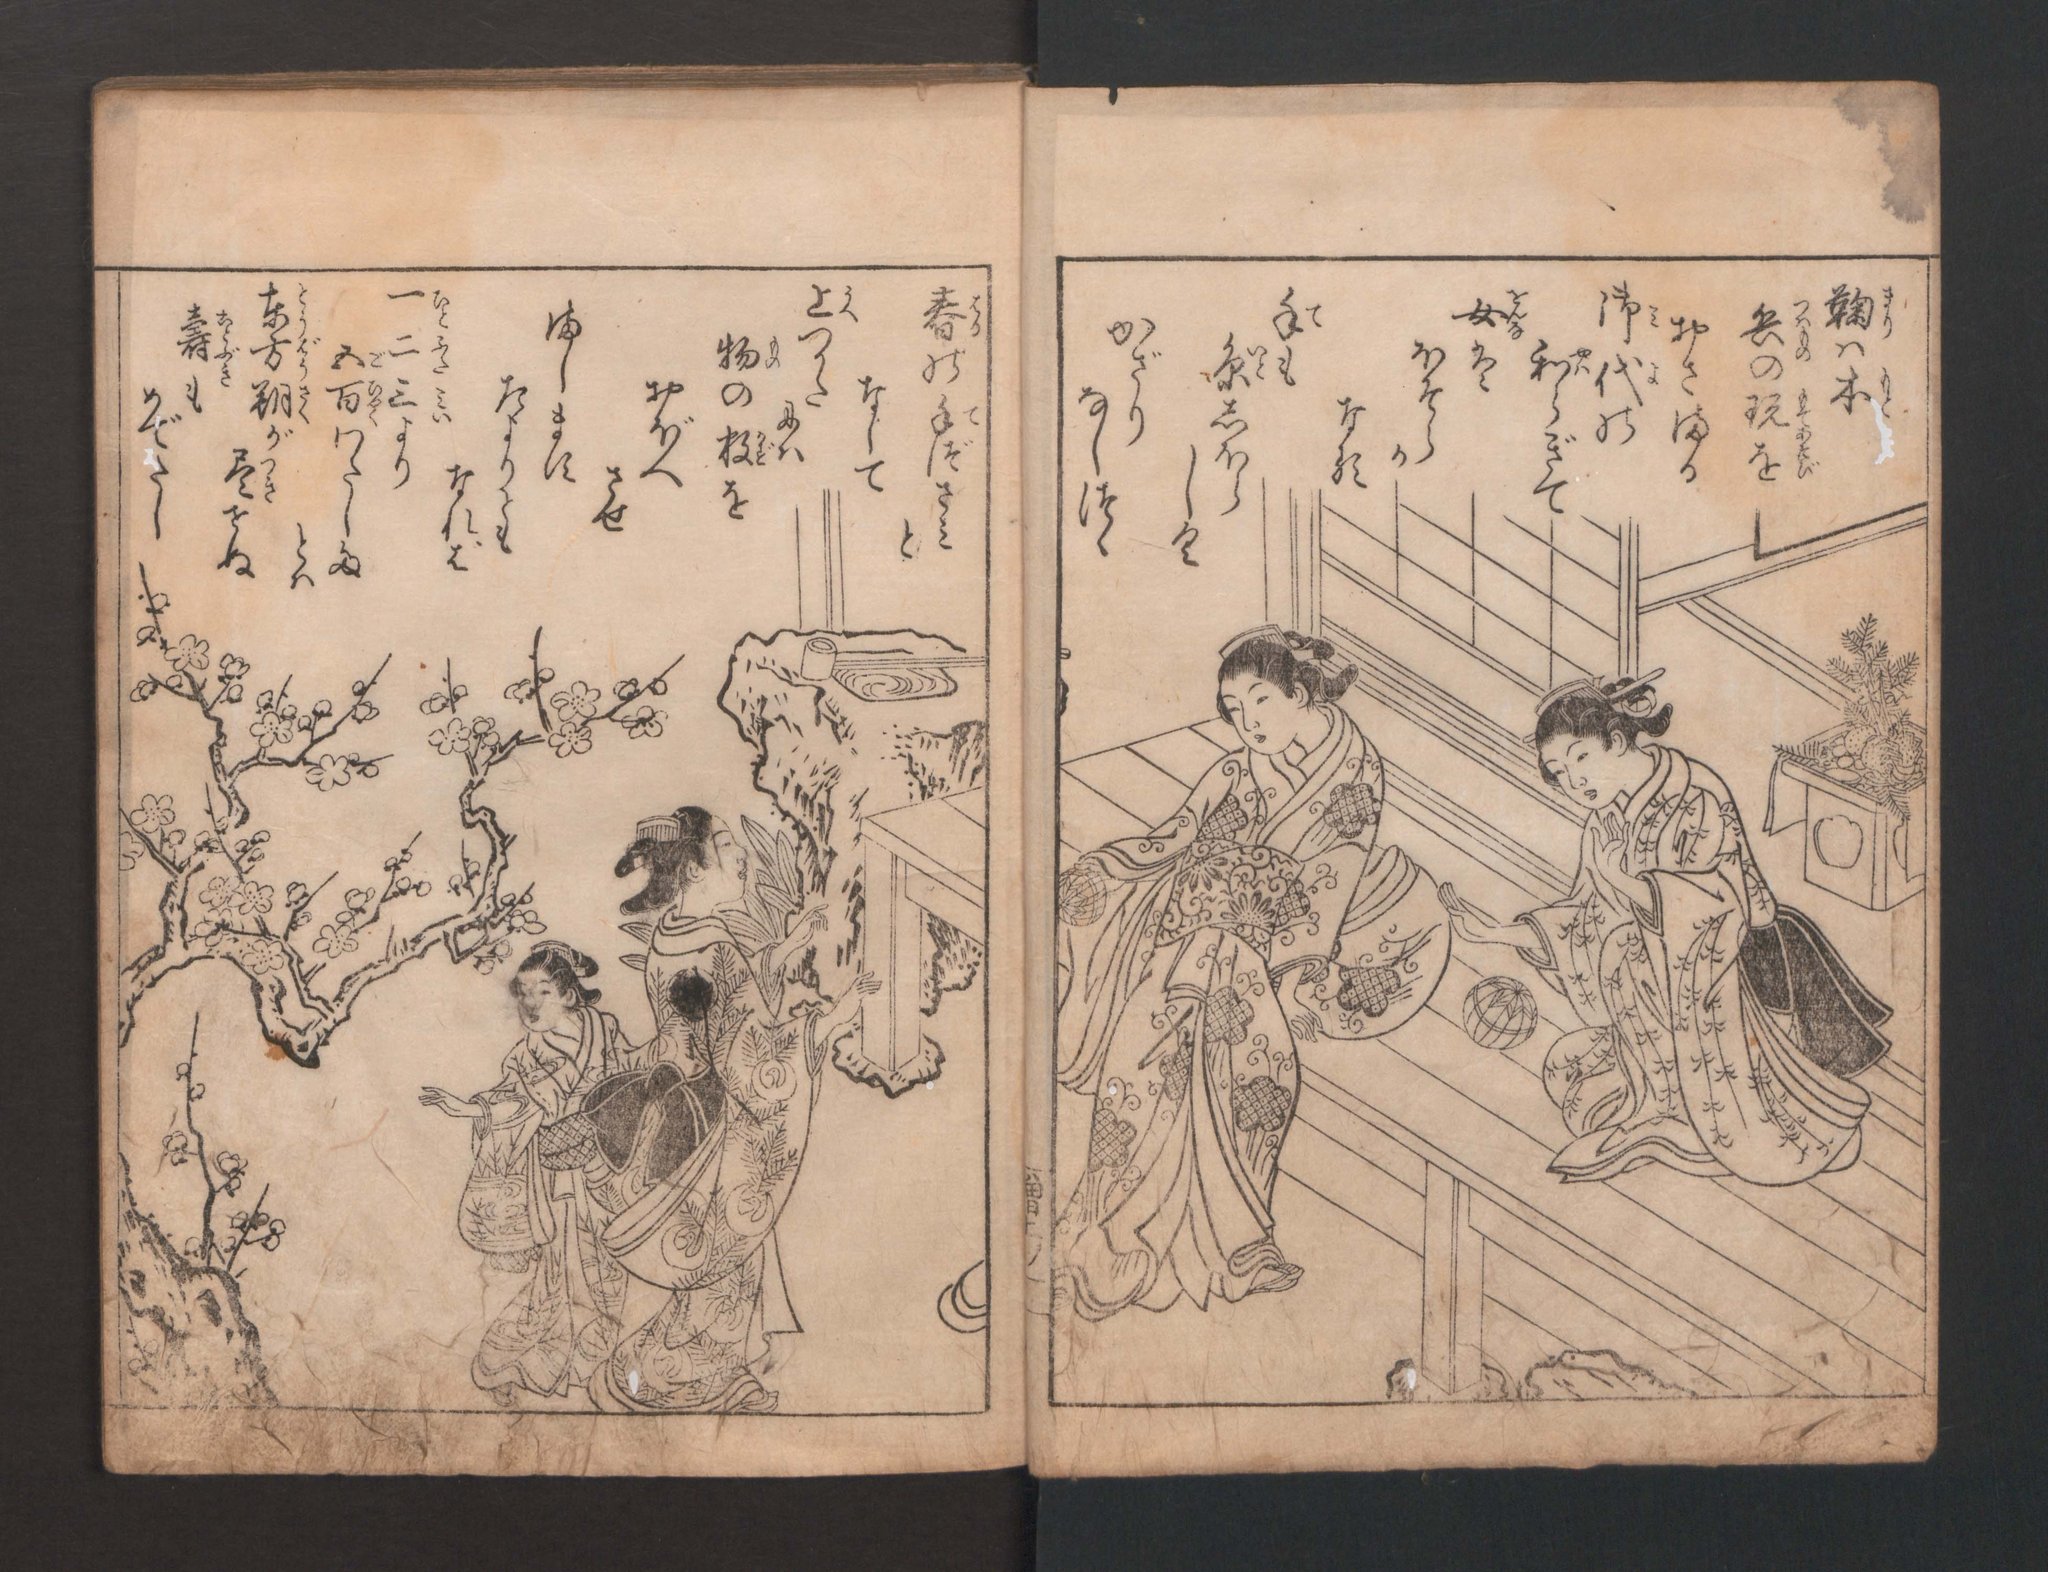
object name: illustrated book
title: True Reflections on the Life and Manners of a Woman (Ehon Masukagami) 絵本十寸鏡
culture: japanese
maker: nishikawa sukenobu 西川祐信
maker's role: artist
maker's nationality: japanese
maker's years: 1671-1750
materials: ink, paper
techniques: woodblock print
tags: women,trees